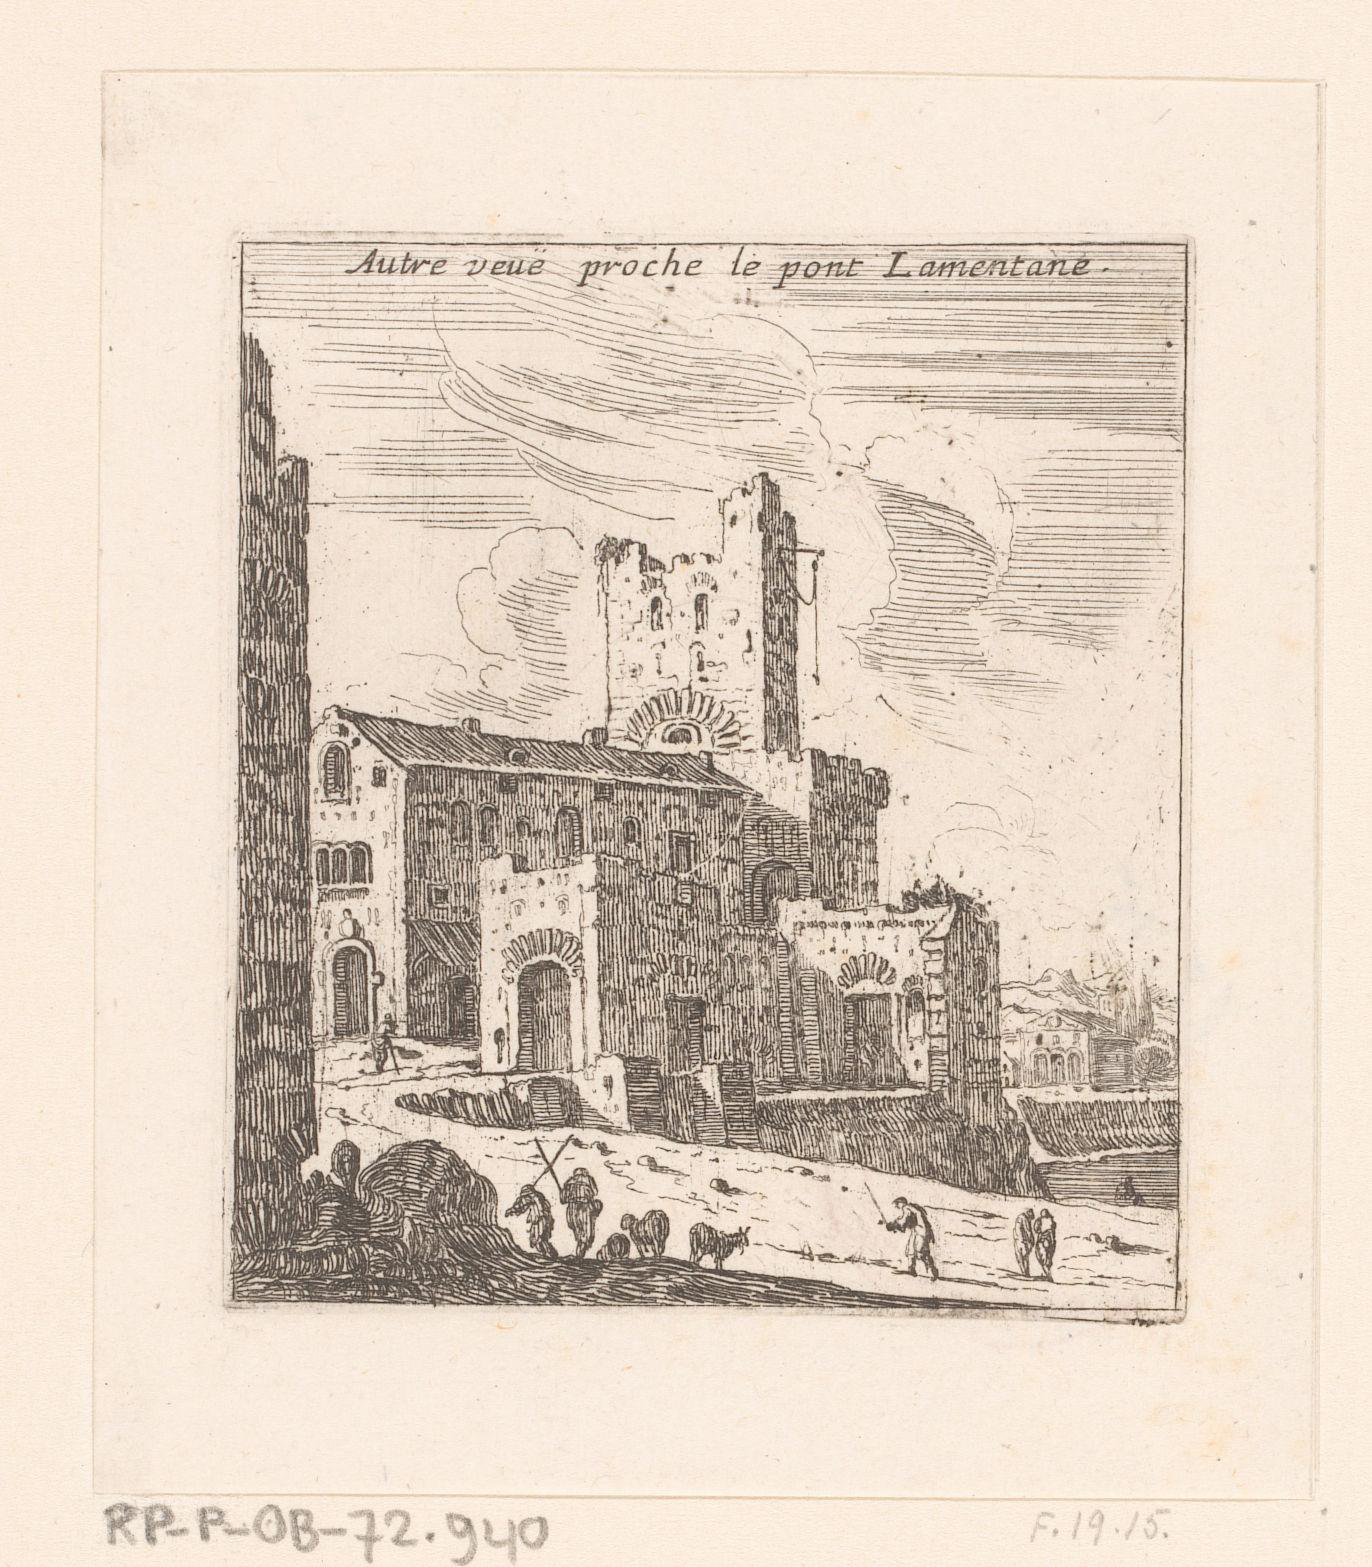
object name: print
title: Diverse gezichten op Italië en andere plaatsen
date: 1631-1661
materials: paper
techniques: etching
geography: france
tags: bridge in city across river, canal, etc.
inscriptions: collector's mark: Lugt 240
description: Prent maakt deel uit van een ongenummerde serie van 22 prenten.